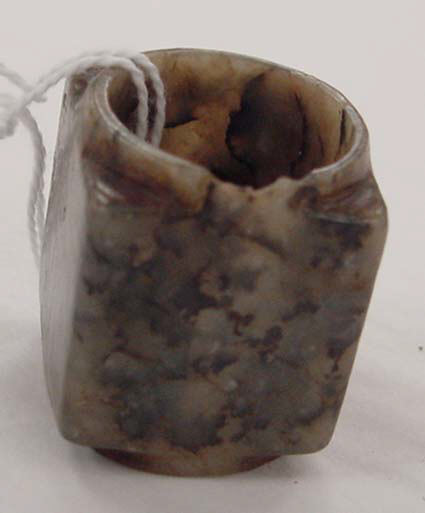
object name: ring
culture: chinese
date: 1801-1900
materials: jade